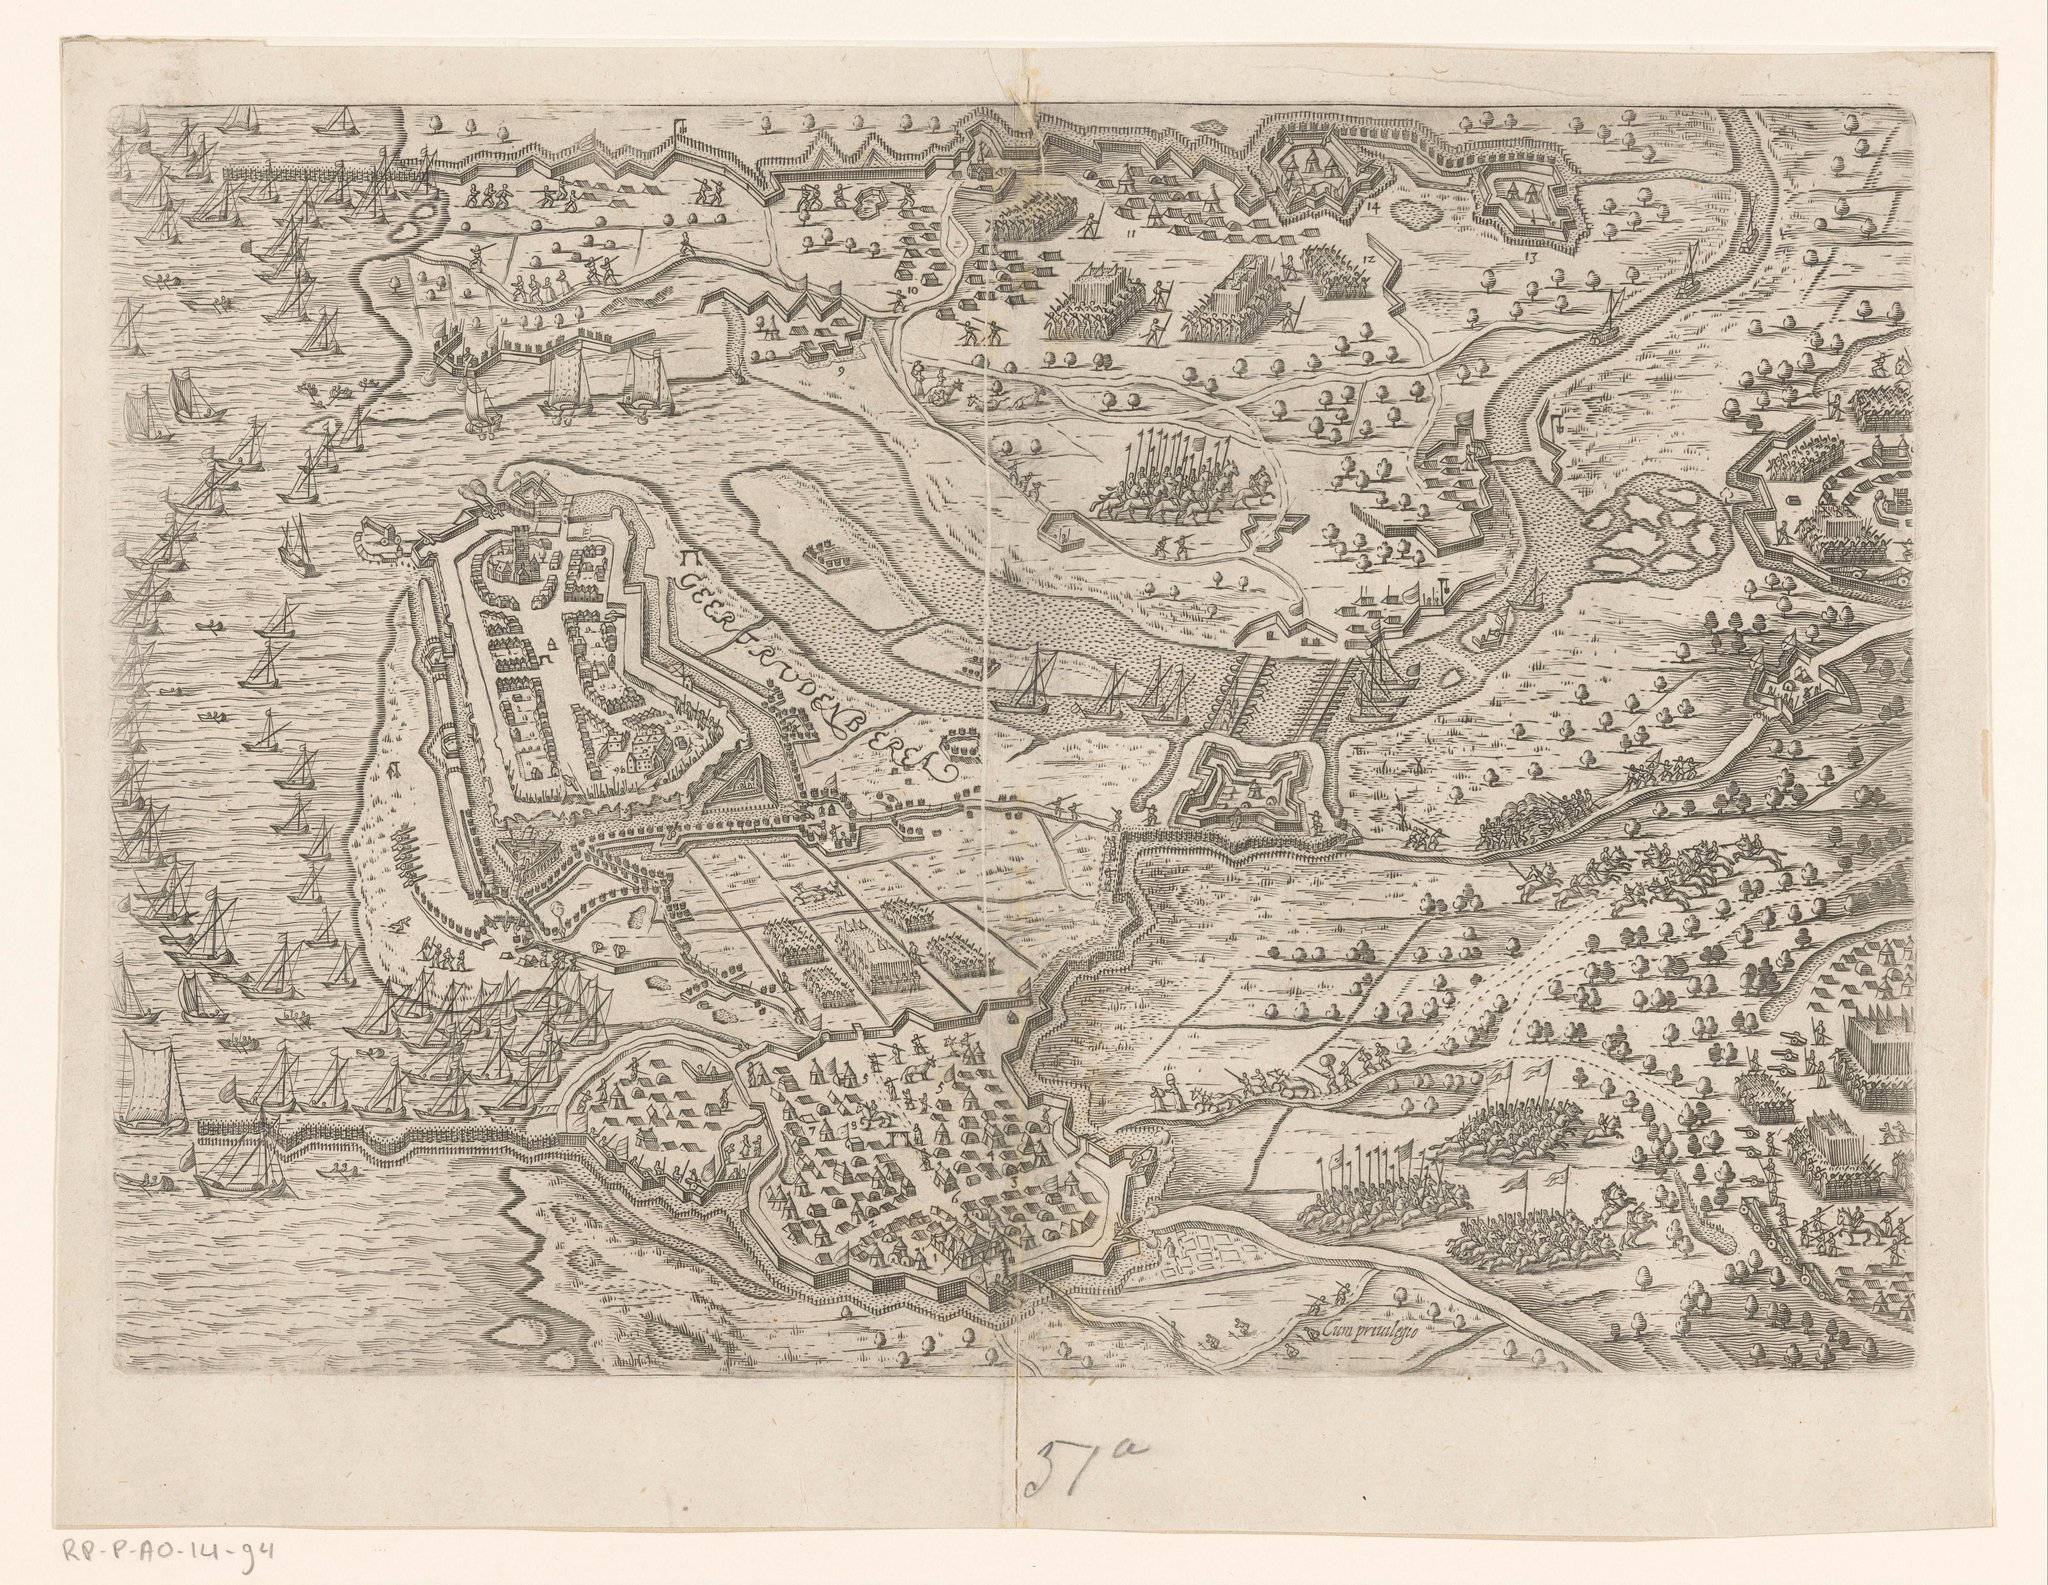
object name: print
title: Beleg van Geertruidenberg, 1593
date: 1601-1612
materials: paper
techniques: engraving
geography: northern netherlands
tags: the hague, maurice (prince of orange), maps of separate countries or regions, siege, position war, geertruidenberg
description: Prent met daaronder tekst in boekdruk ook gebruikt in: Orlers, Jan Jansz. Den Nassauschen Lauren-Crans: Beschrijvinghe ende af-beeldinge van alle de victorien (...) die Godt Almachtich de (...) Staten der Vereenichde Neder-landen verleent heeft, deur het wijs ende clouck beleyt des Hooch-ghebooren Fursts Maurits van Nassau. Leiden: Jan Jansz. Orlers en Henrick Lodewijcxsoon van Haestens, 1610, fol. 90/91. Zonder deze tekst onder de afbeelding (zoals huidige exemplaar) is de prent ook gebruikt in: Orlers, Jan Jansz. Les lauriers de Nassau: Description & representation de toutes les victoires (…) lesquelles Dieu a octroiees aux (…) Estats des Provinces Vnies du Païs-Bas, souz la conduite & gouuernement de Son Excellence, le prince Mavrice de Nassav. Leiden: Jan Jansz. Orlers en Henrick Lodewijcxsoon van Haestens, 1612, fol. 108/109.